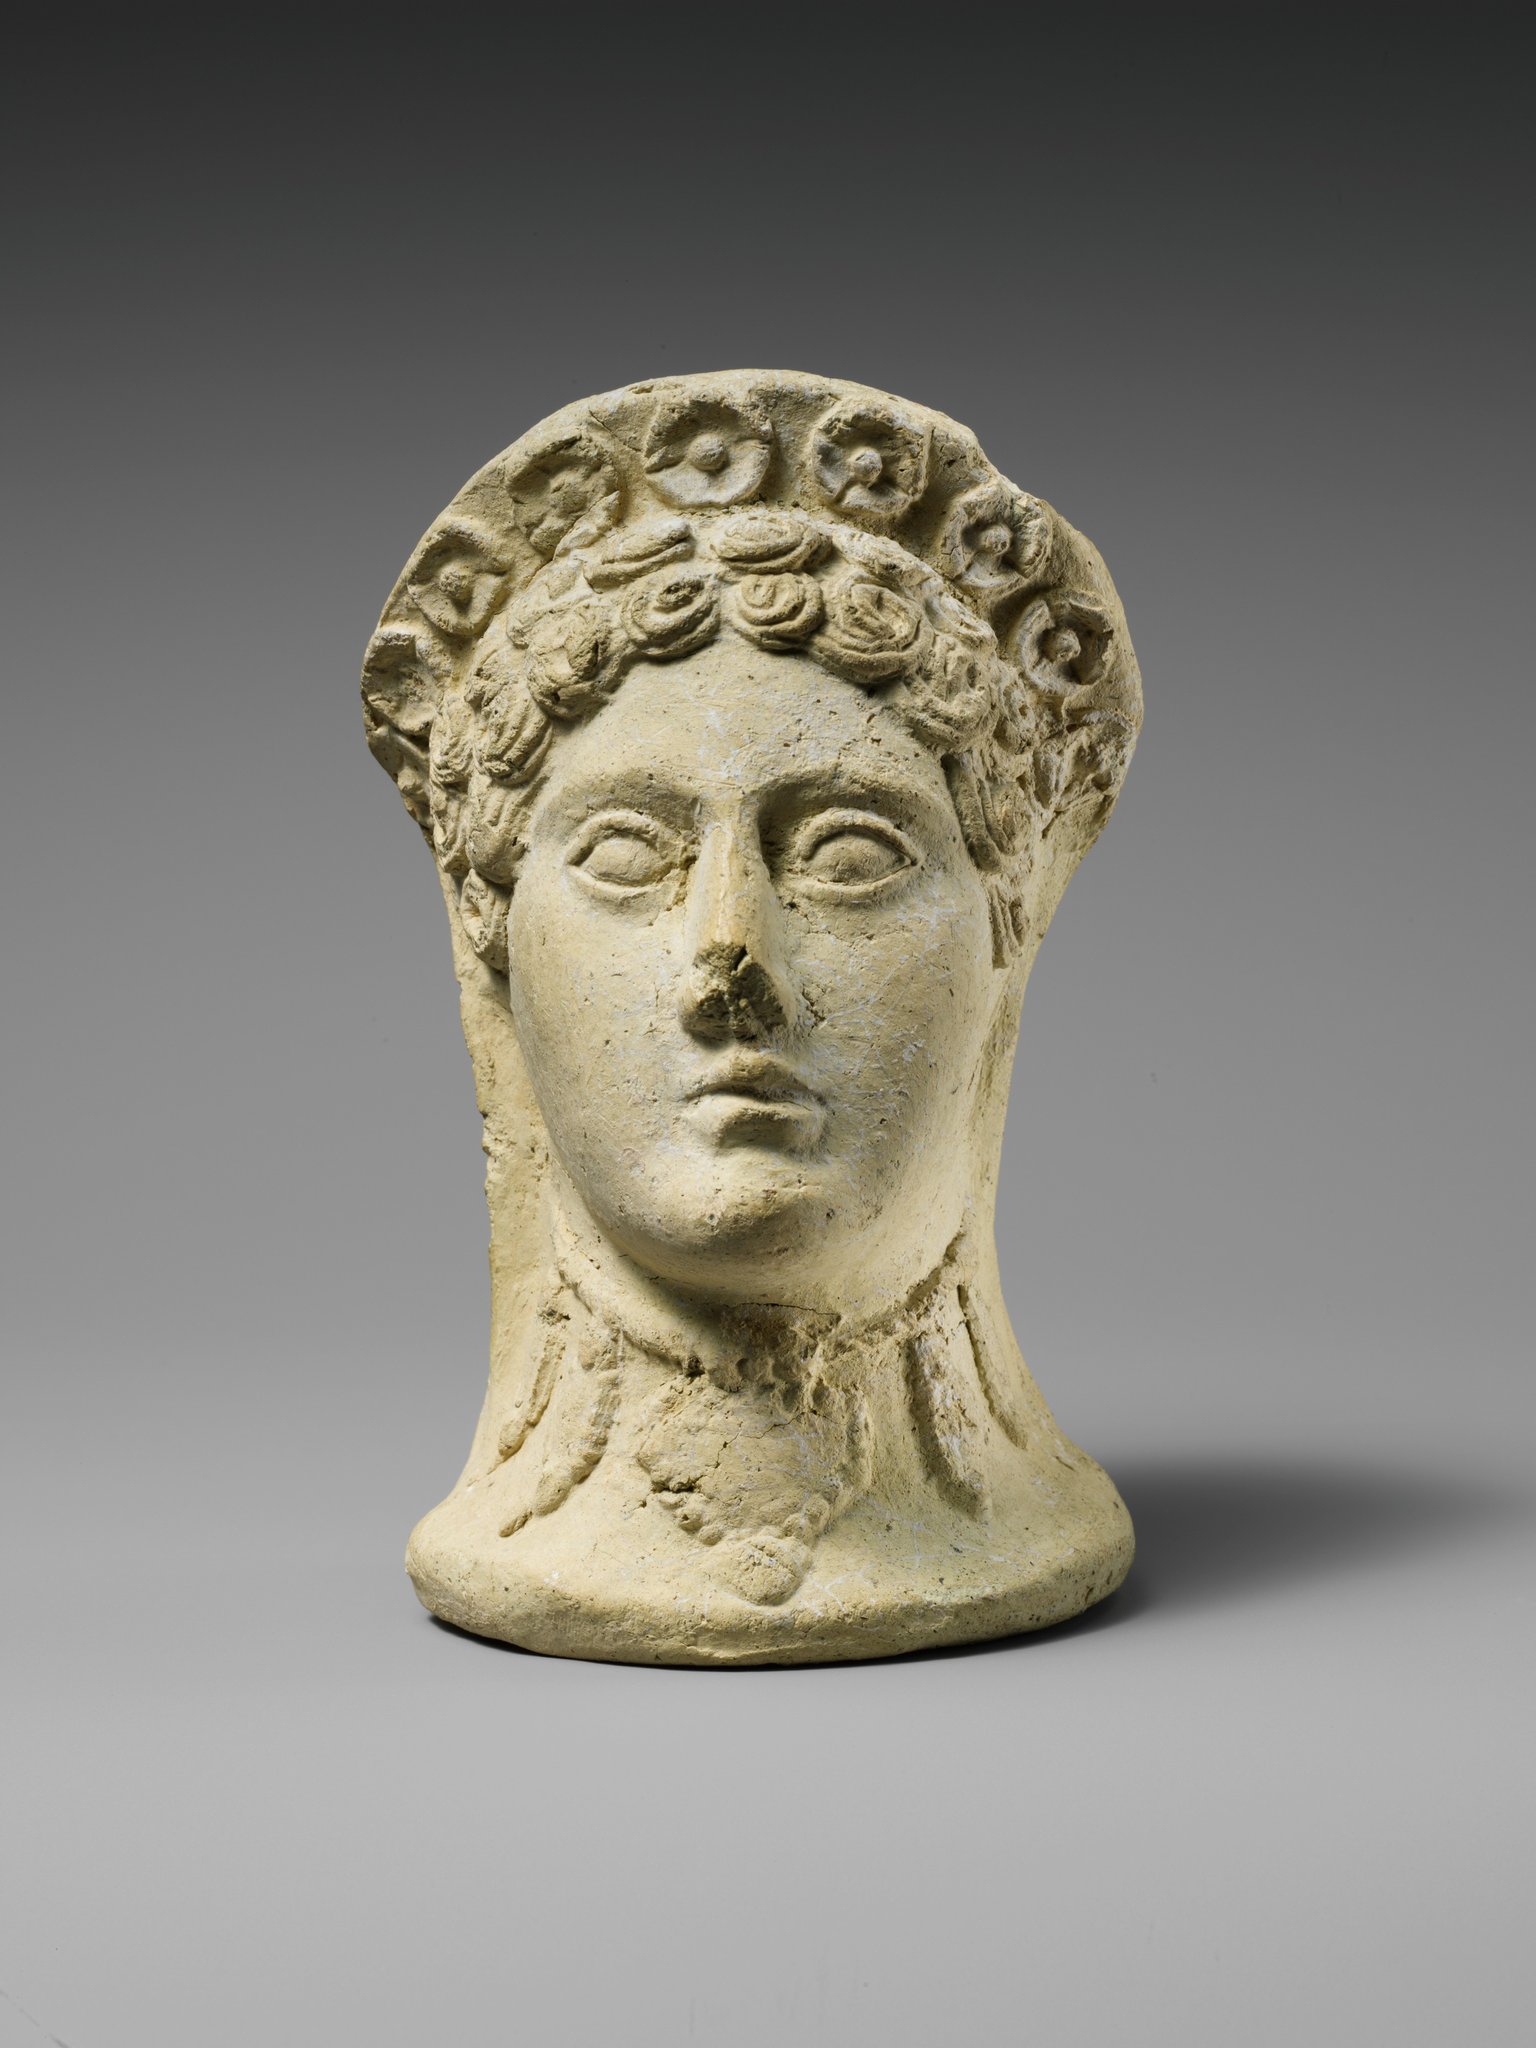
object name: head of a woman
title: Terracotta head of a woman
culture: etruscan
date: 400-301 BCE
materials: terracotta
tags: diadems,necklaces,heads,women